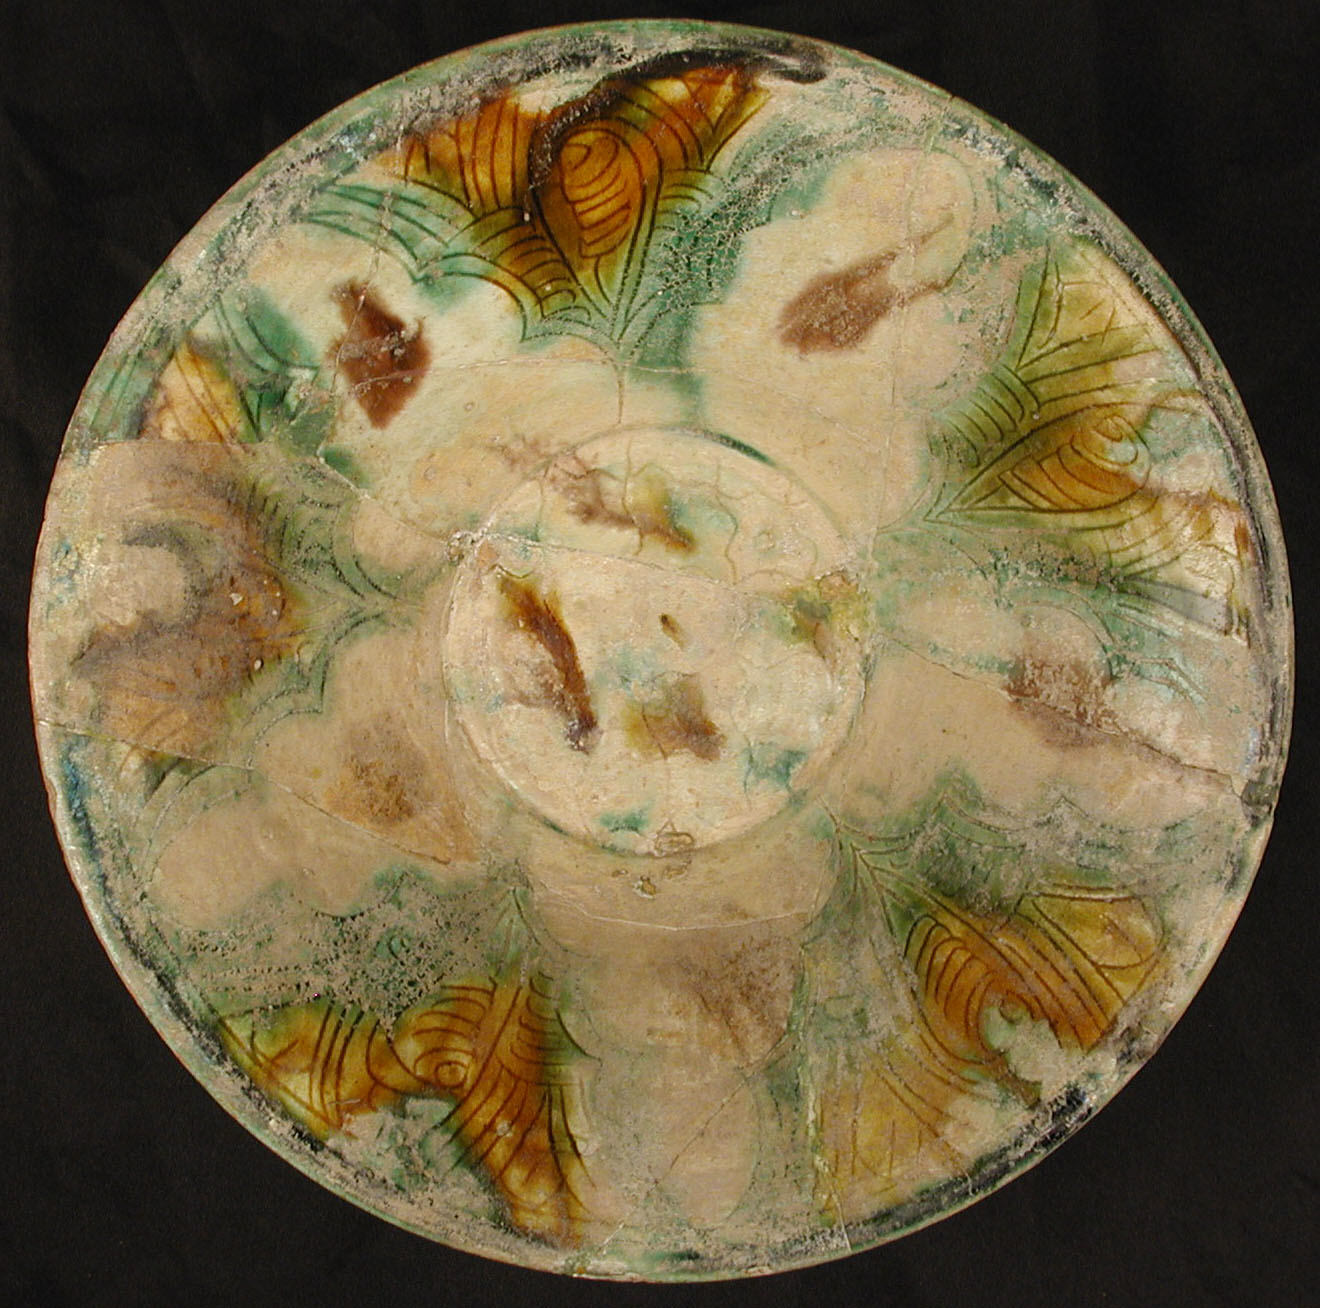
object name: bowl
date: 901-1000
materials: earthenware, glaze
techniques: incising, polychrome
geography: iran